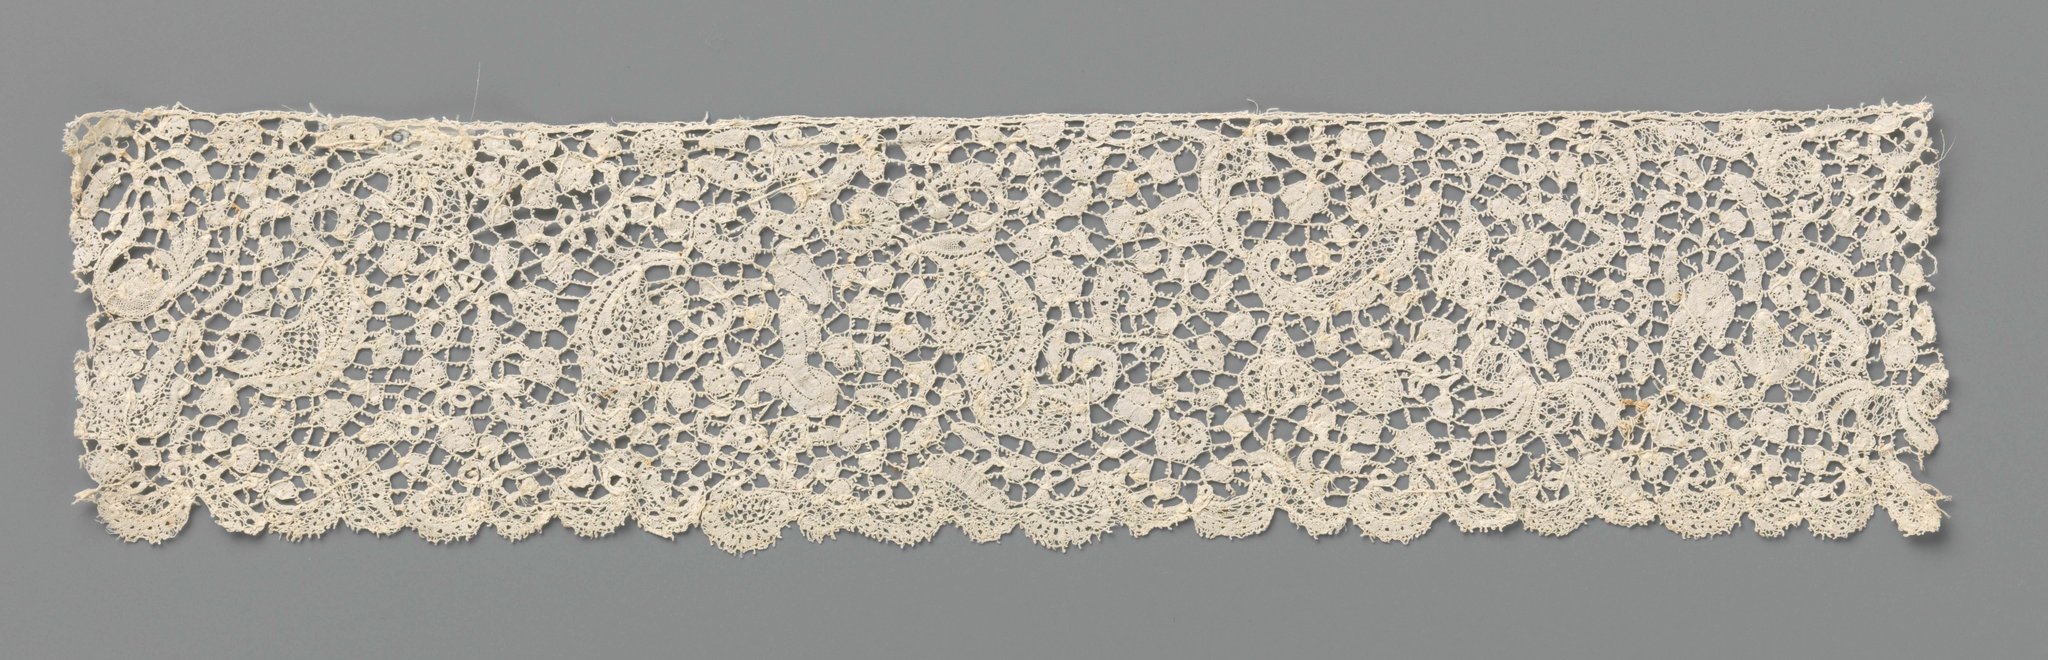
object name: strip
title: Strook kloskant met vrouwenborstbeeldje en dolfijn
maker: Anonymous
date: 1680-1720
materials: linen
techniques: lace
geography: southern netherlands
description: Strook naturelkleurige Brusselse kloskant. Het patroon bestaat uit vele kleine motiefjes, waarbij het vrouwenborstbeeldje, iets rechts van het midden, en de waterspuwende dolfijn, aan de linkerkant van de strook, het meest opvallen. Langs de onderzijde zijn veelal c-vormige motiefjes aaneengeschakeld tot een rand met schulpjes. De motieven zijn met elkaar verbonden door een vlechtengrond, met gepicoteerde vlechten. De motieven zijn gemaakt in linnenslag met uitsparingen, deels met opengewerkte randjes en deels met gekloste reliëfcontouren. Er zijn verschillende siergronden toegepast in de motiefjes, waaronder een siergrond met vierkantjes gemaakt in vormslag. De bovenzijde is recht afgewerkt. De schulpjes langs onderzijde zijn afgewerkt met picots.